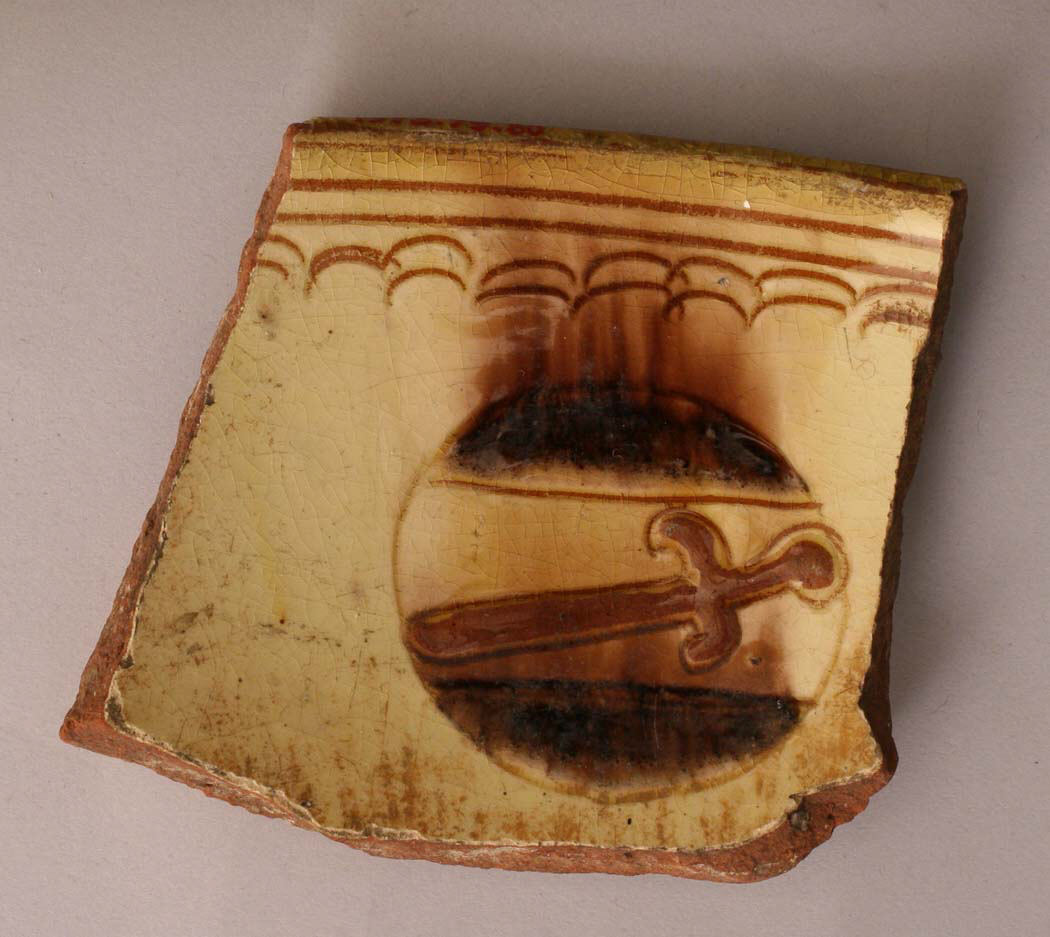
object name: fragment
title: Ceramic Fragment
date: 1301-1400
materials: earthenware, glaze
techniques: incising, painting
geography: egypt